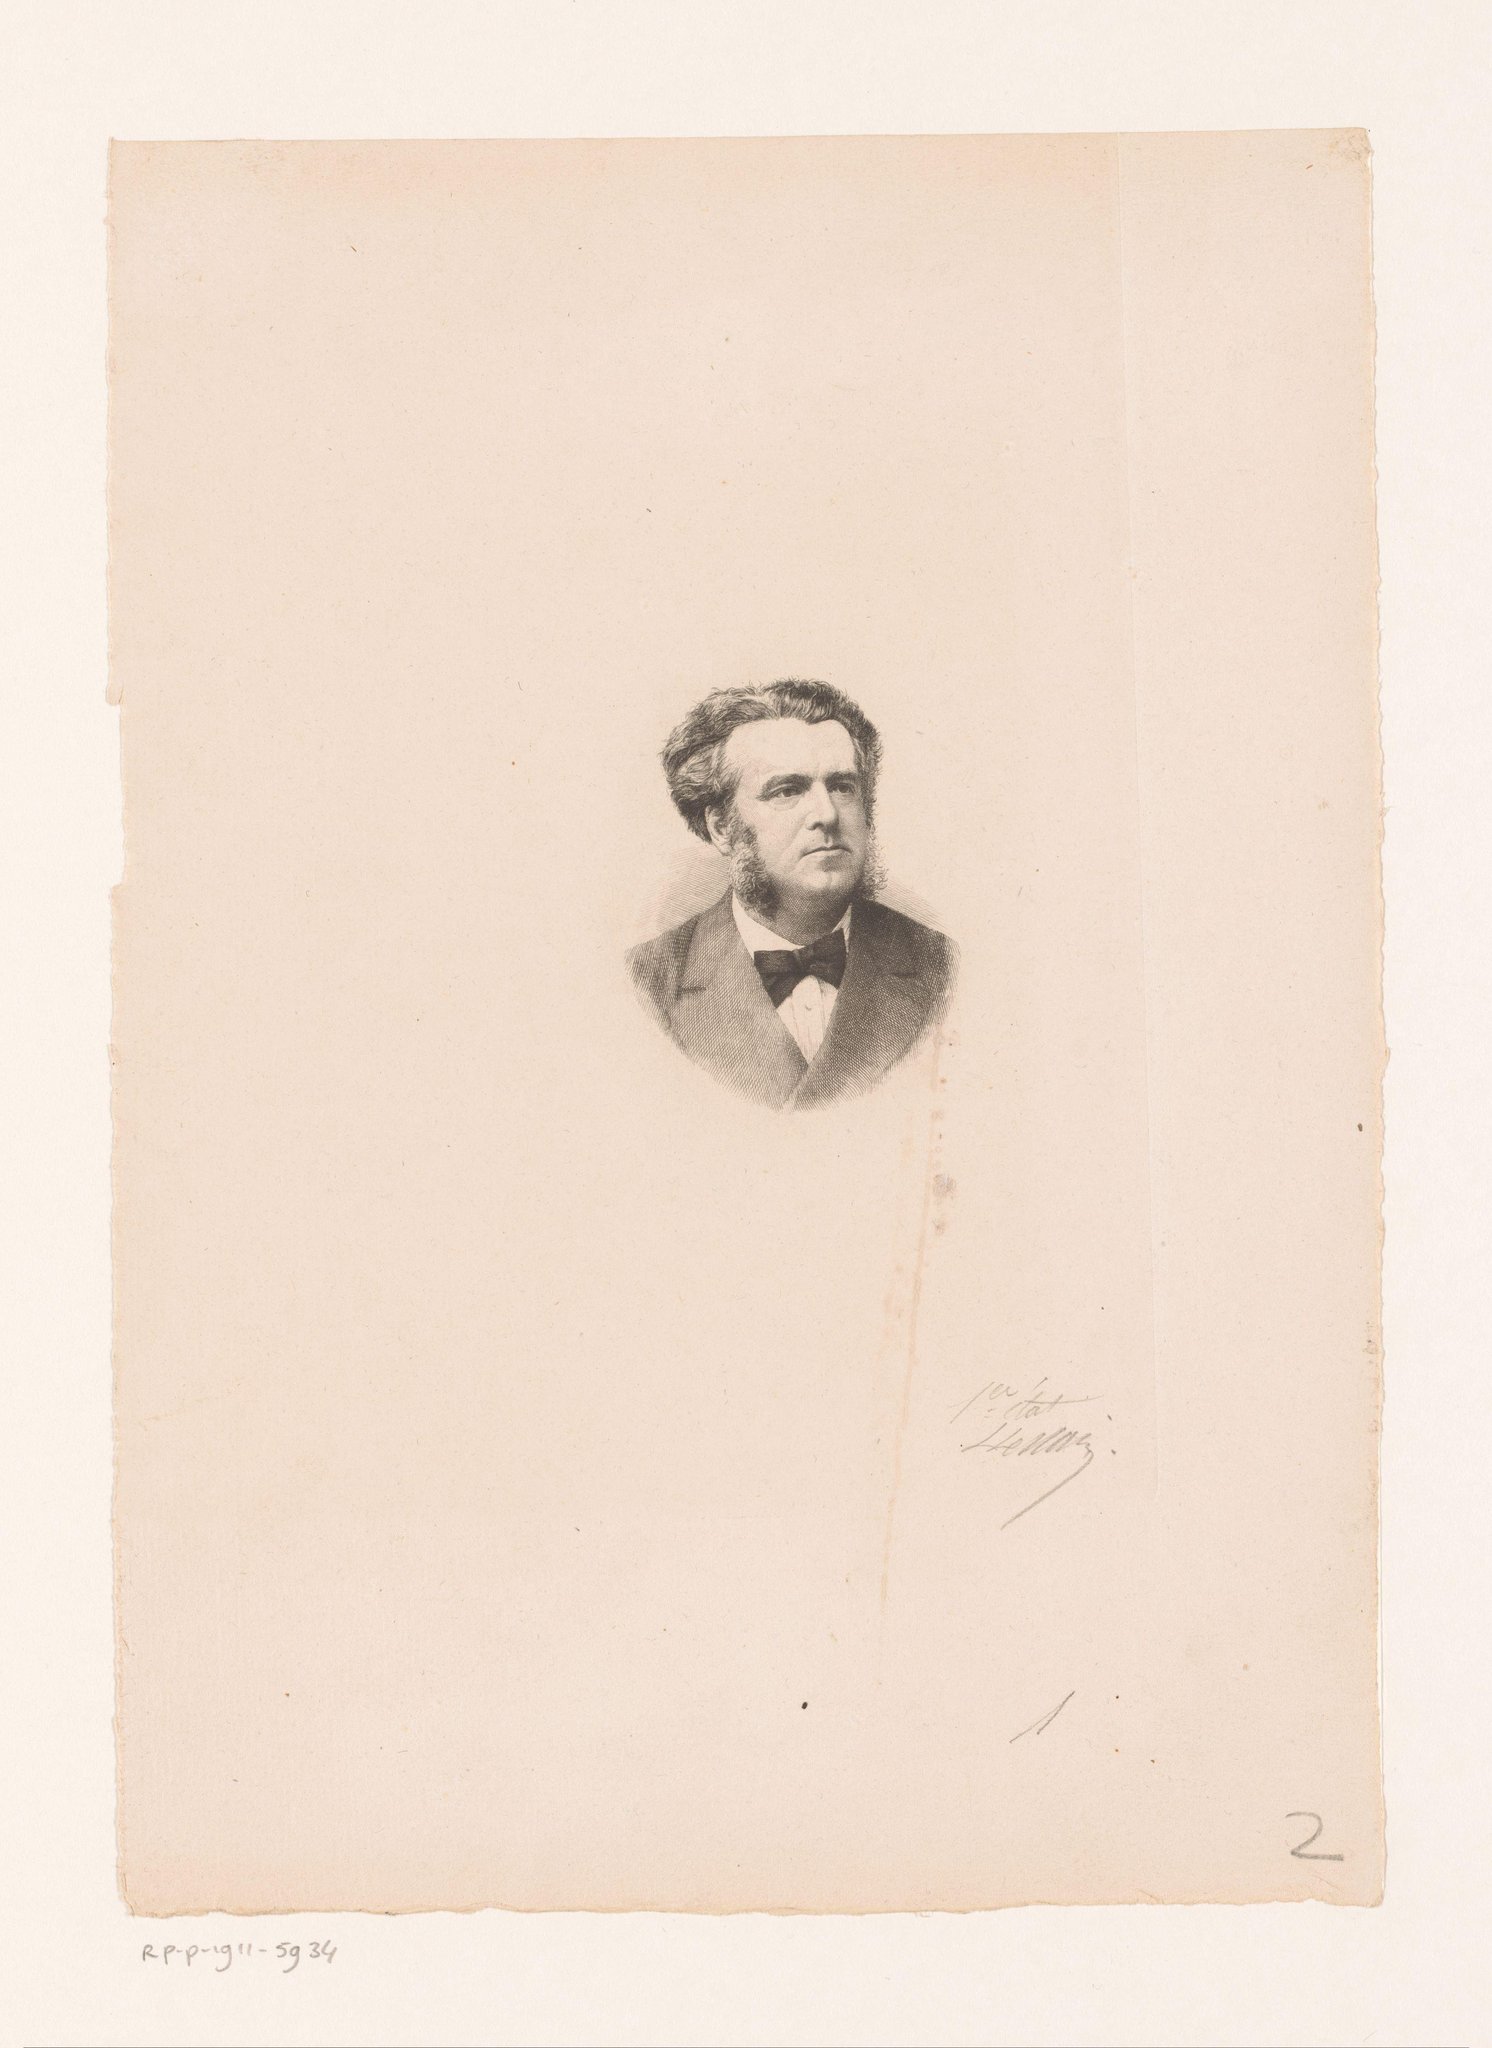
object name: print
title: Portret van Charles Floquet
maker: louis le nain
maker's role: print maker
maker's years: 1851-1939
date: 1861-1911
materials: paper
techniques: etching, intaglio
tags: adult man, historical persons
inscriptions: inscription: ‘1er état Lle Nain’, collector's mark: Lugt 2228